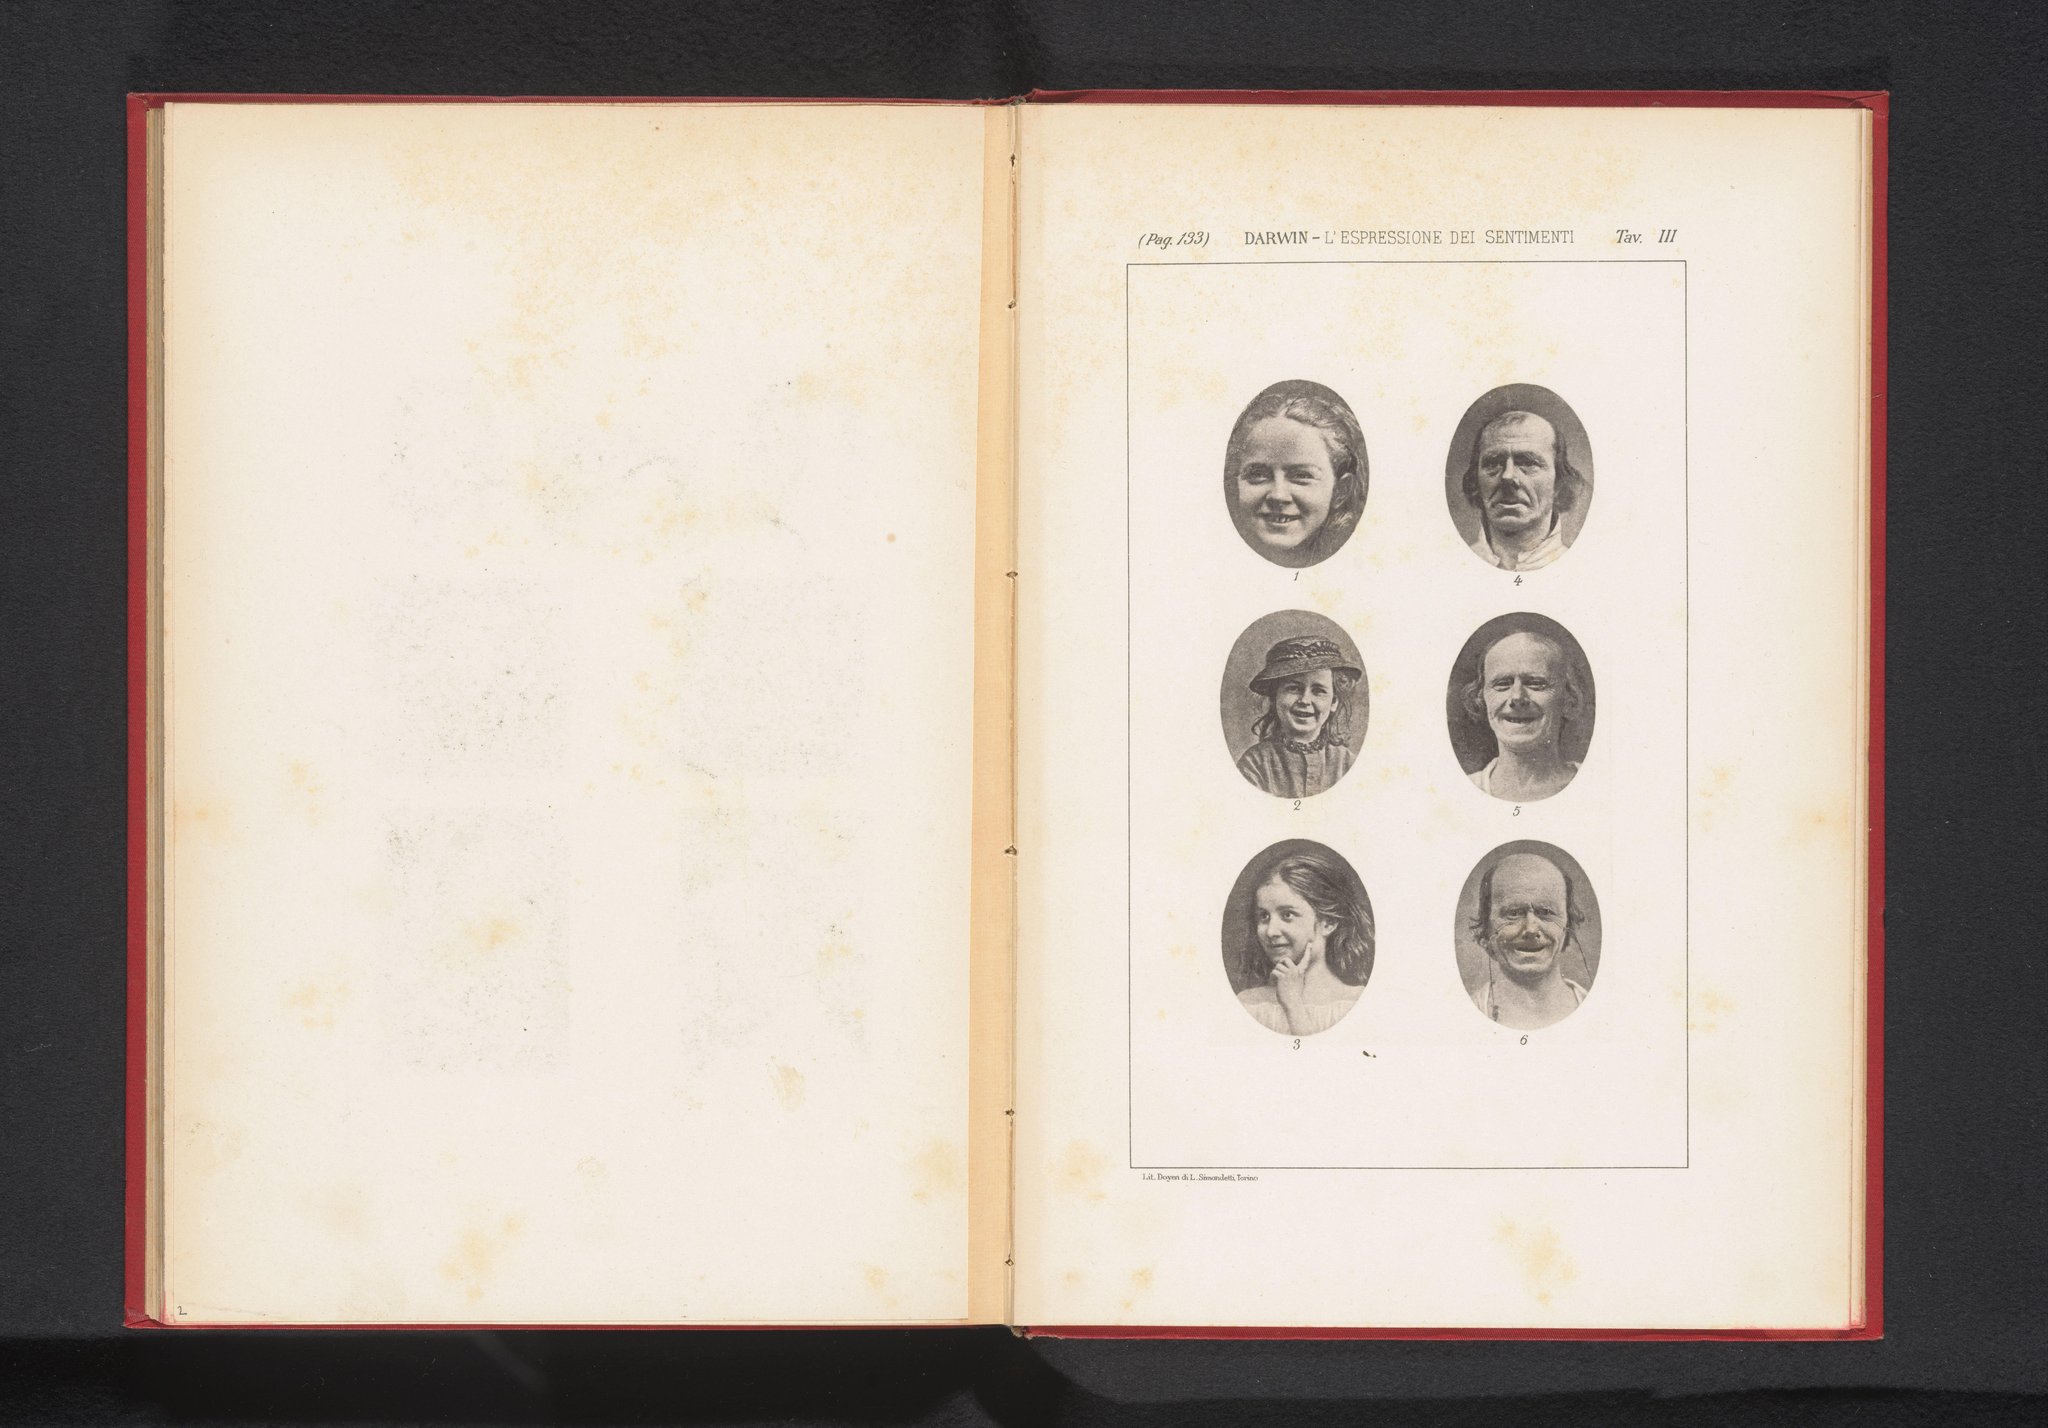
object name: photomechanical print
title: Zes portretten van onbekende mensen en kinderen die vreugde tonen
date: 1880-1890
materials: paper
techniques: photograph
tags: passions, emotions, affections, laughing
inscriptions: number: ‘Tav. III 1 2 3 4 5 6 (Pag. 133)’